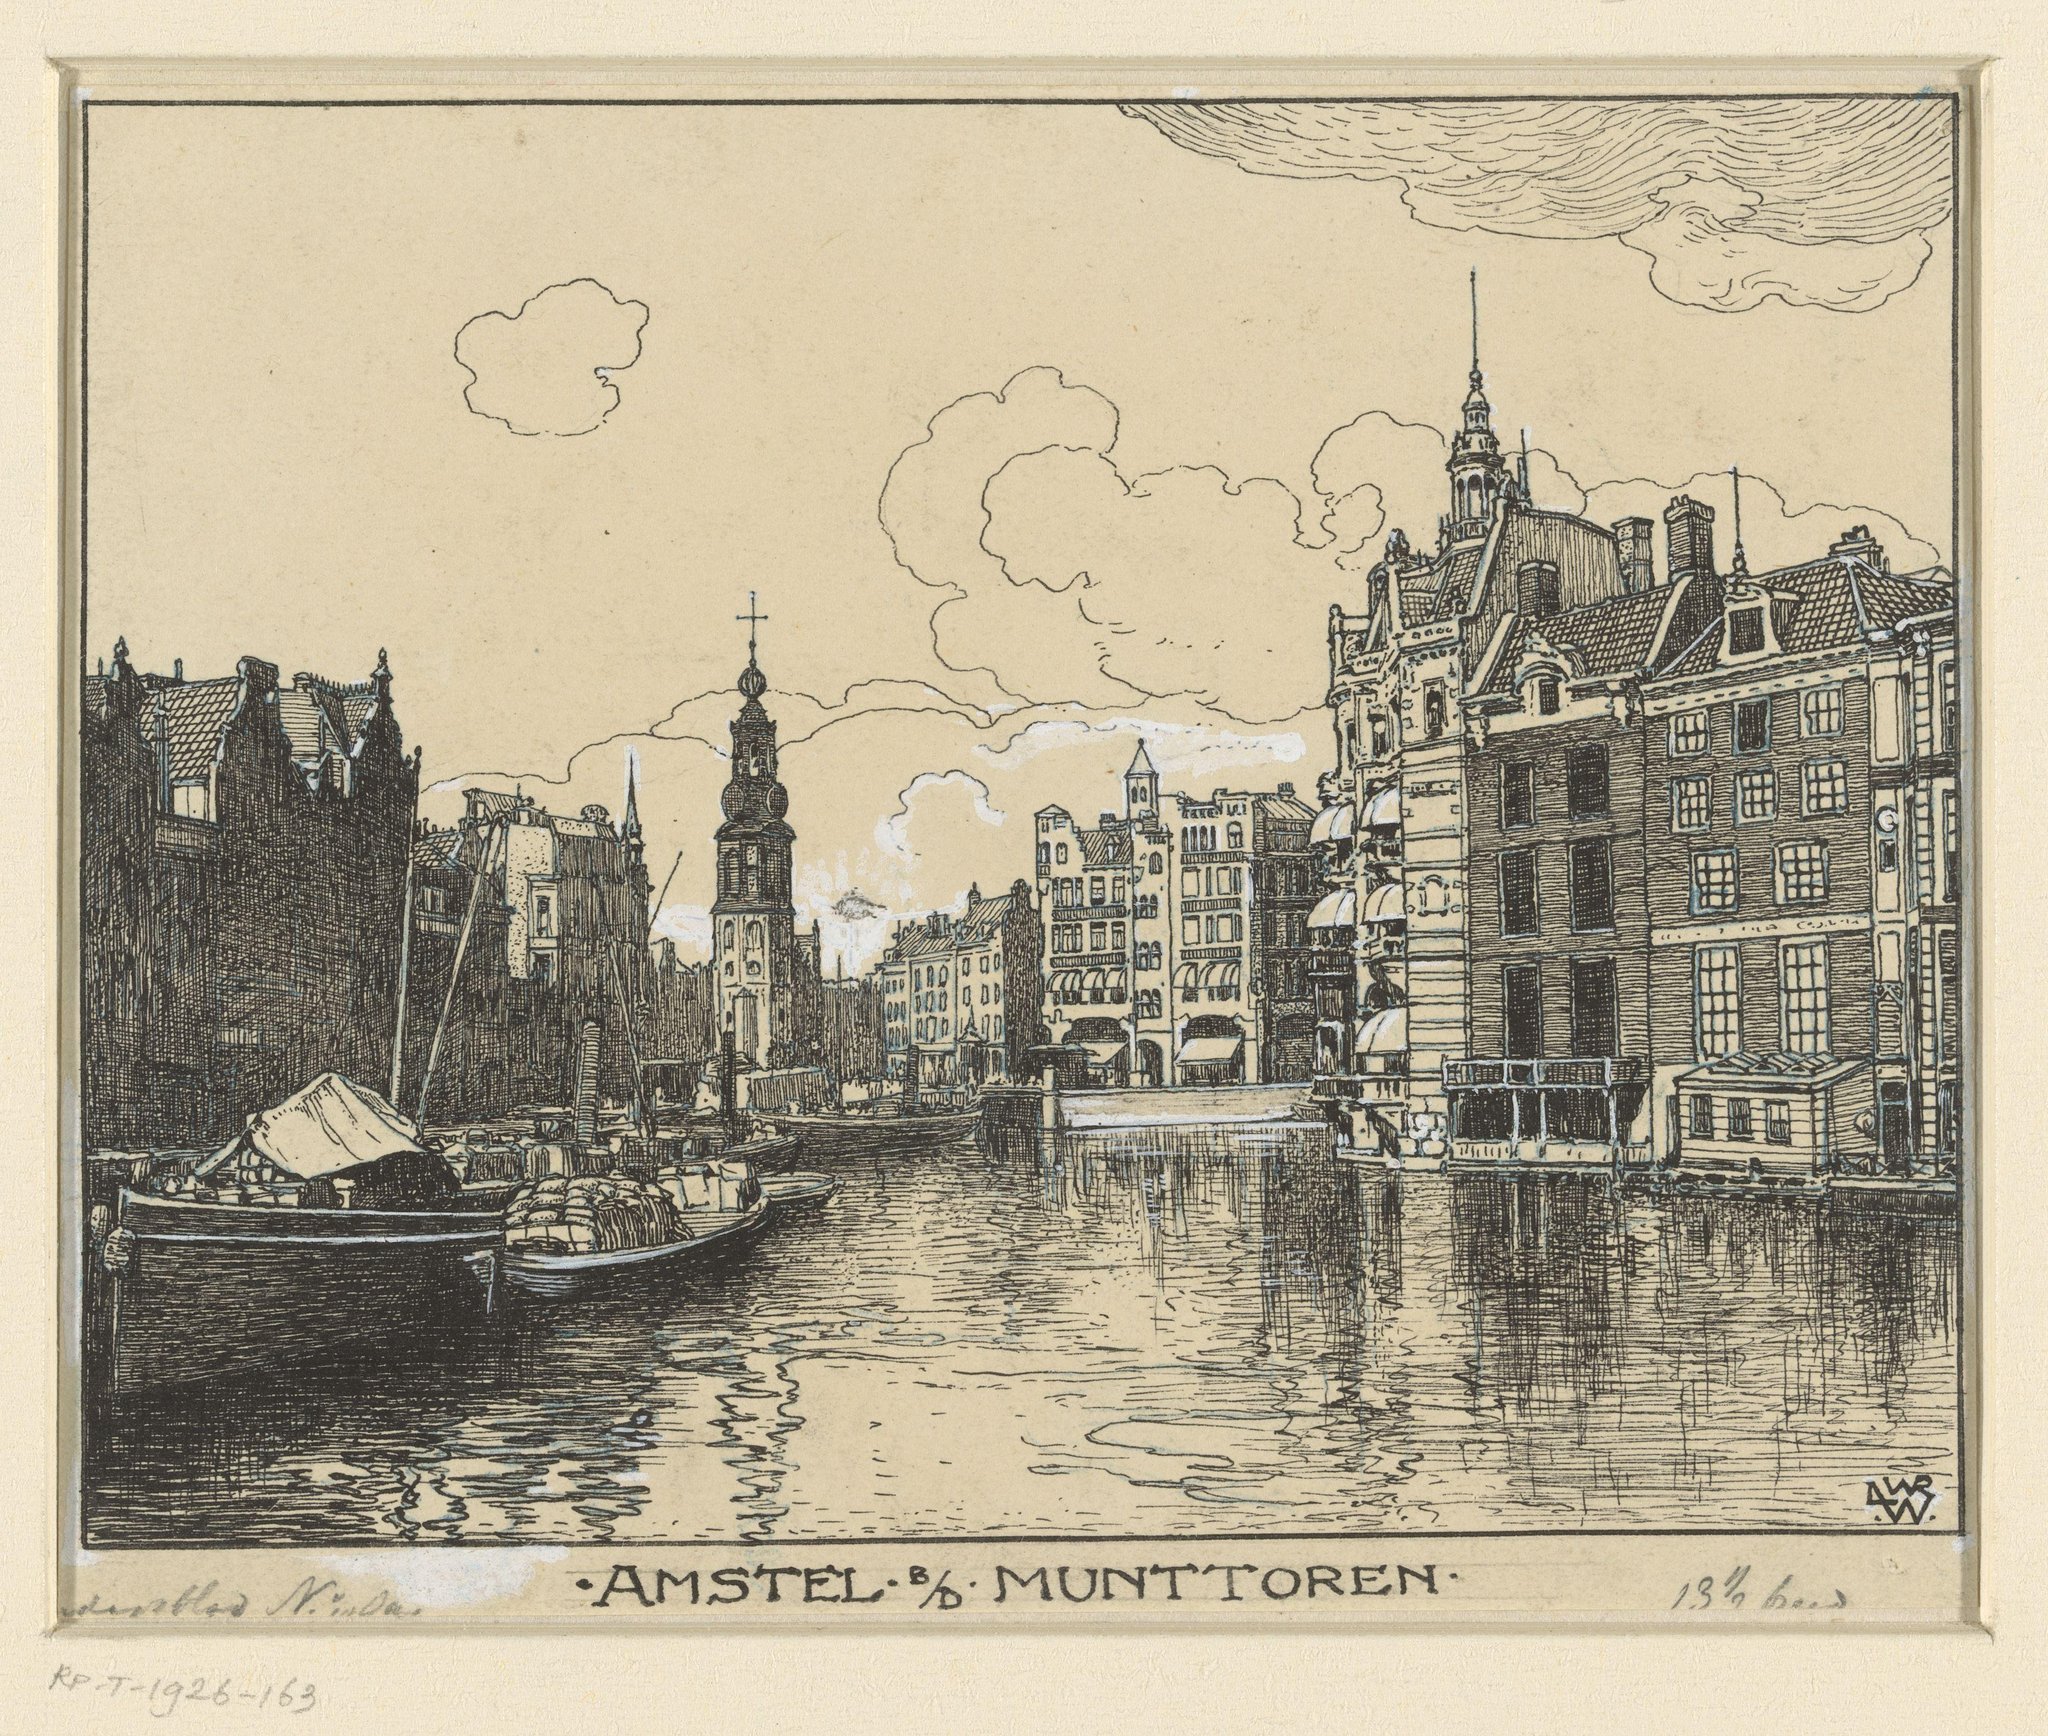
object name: drawing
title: Amstel bij de Munttoren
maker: willem wenckebach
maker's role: designer, draughtsman, painter, print maker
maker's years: 1860-1937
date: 1870-1926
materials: paint, ink, paper, pencil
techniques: pen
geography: amsterdam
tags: canals, waters (in city)